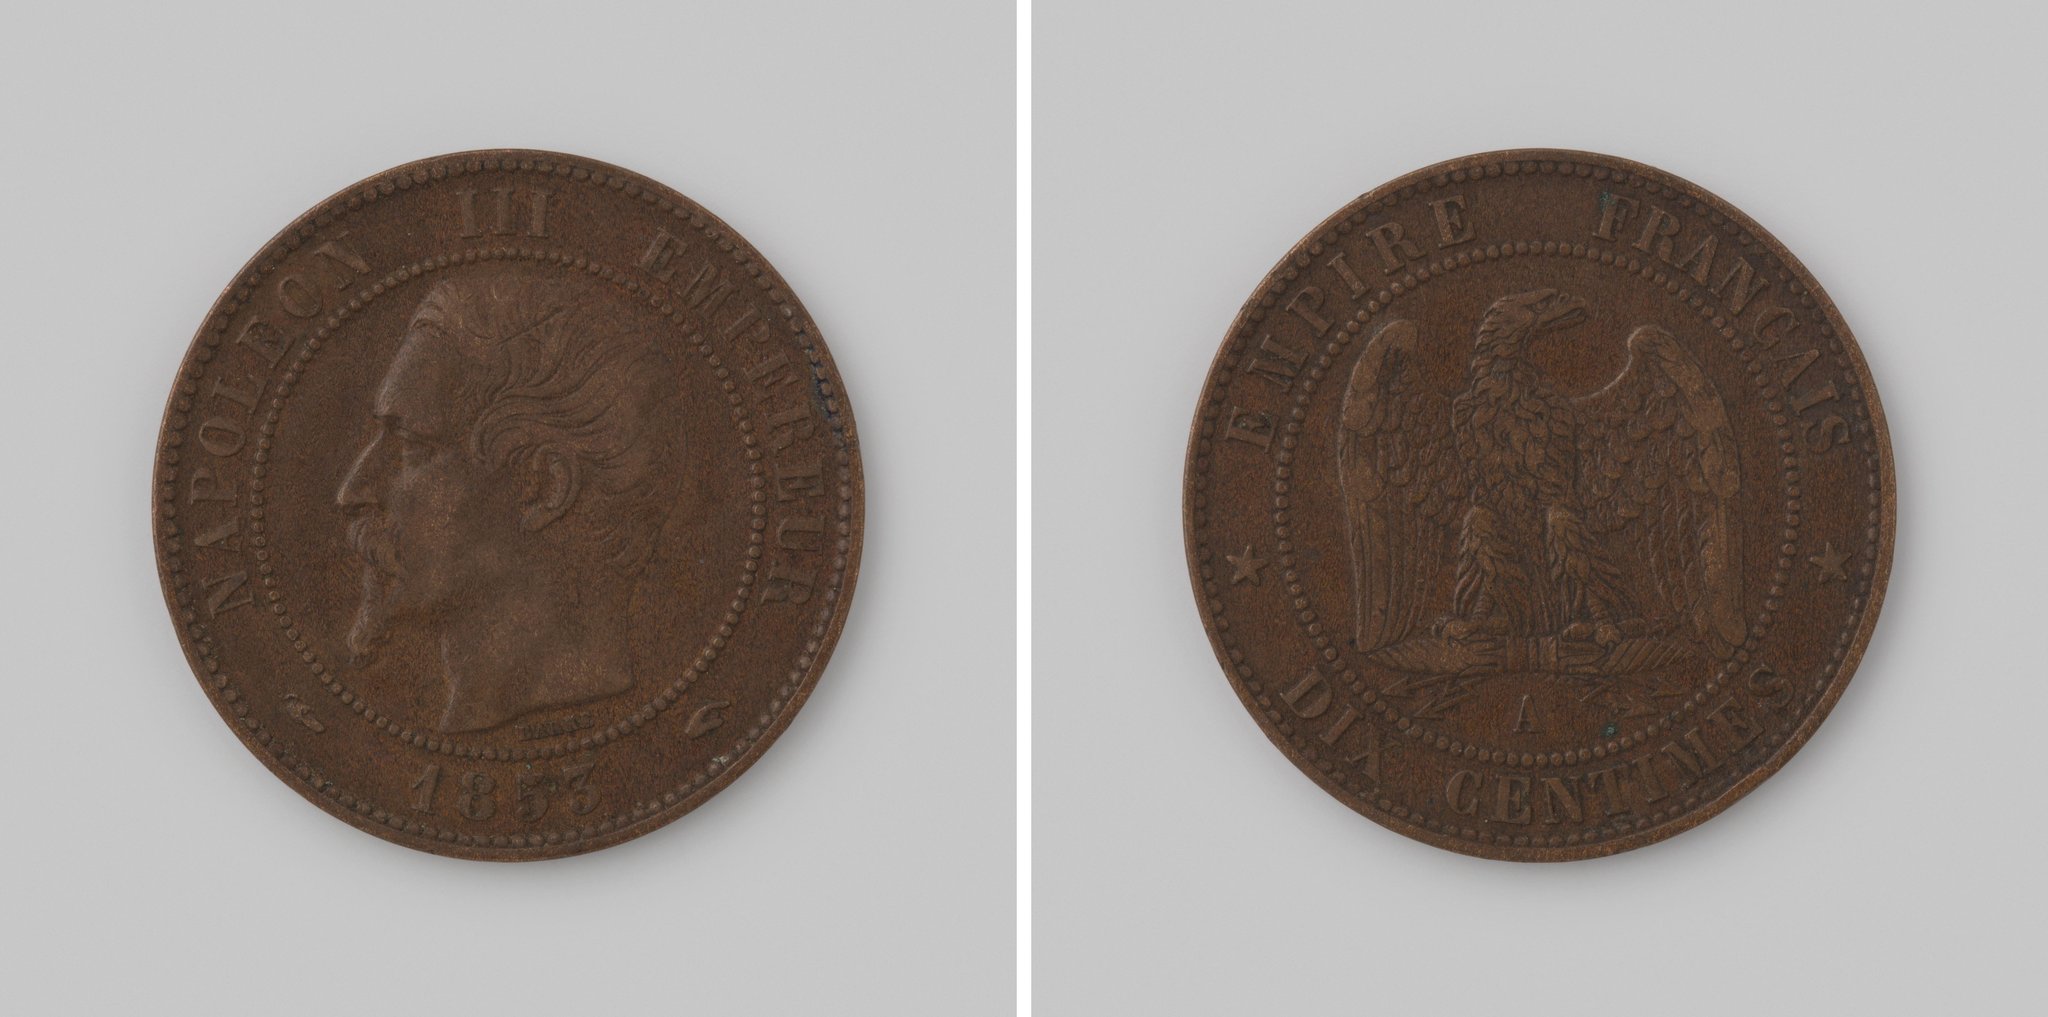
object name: tien centime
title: Keizerrijk Frankrijk, Napoleon III, 10 centimes,1853 A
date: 1853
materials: bronze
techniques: striking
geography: paris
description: Bronzen munt. Voorzijde: hoofd van de keizer naar links. Jaartal onderaan. Keerzijde: op bundel, waaruit bliksemschichten, staande, naar rechts kijkende adelaar met gespreide vleugels, waaronder de letter A [=Parijs]. Waarde-aanduiding onderaan in omschrift. Gladde rand.